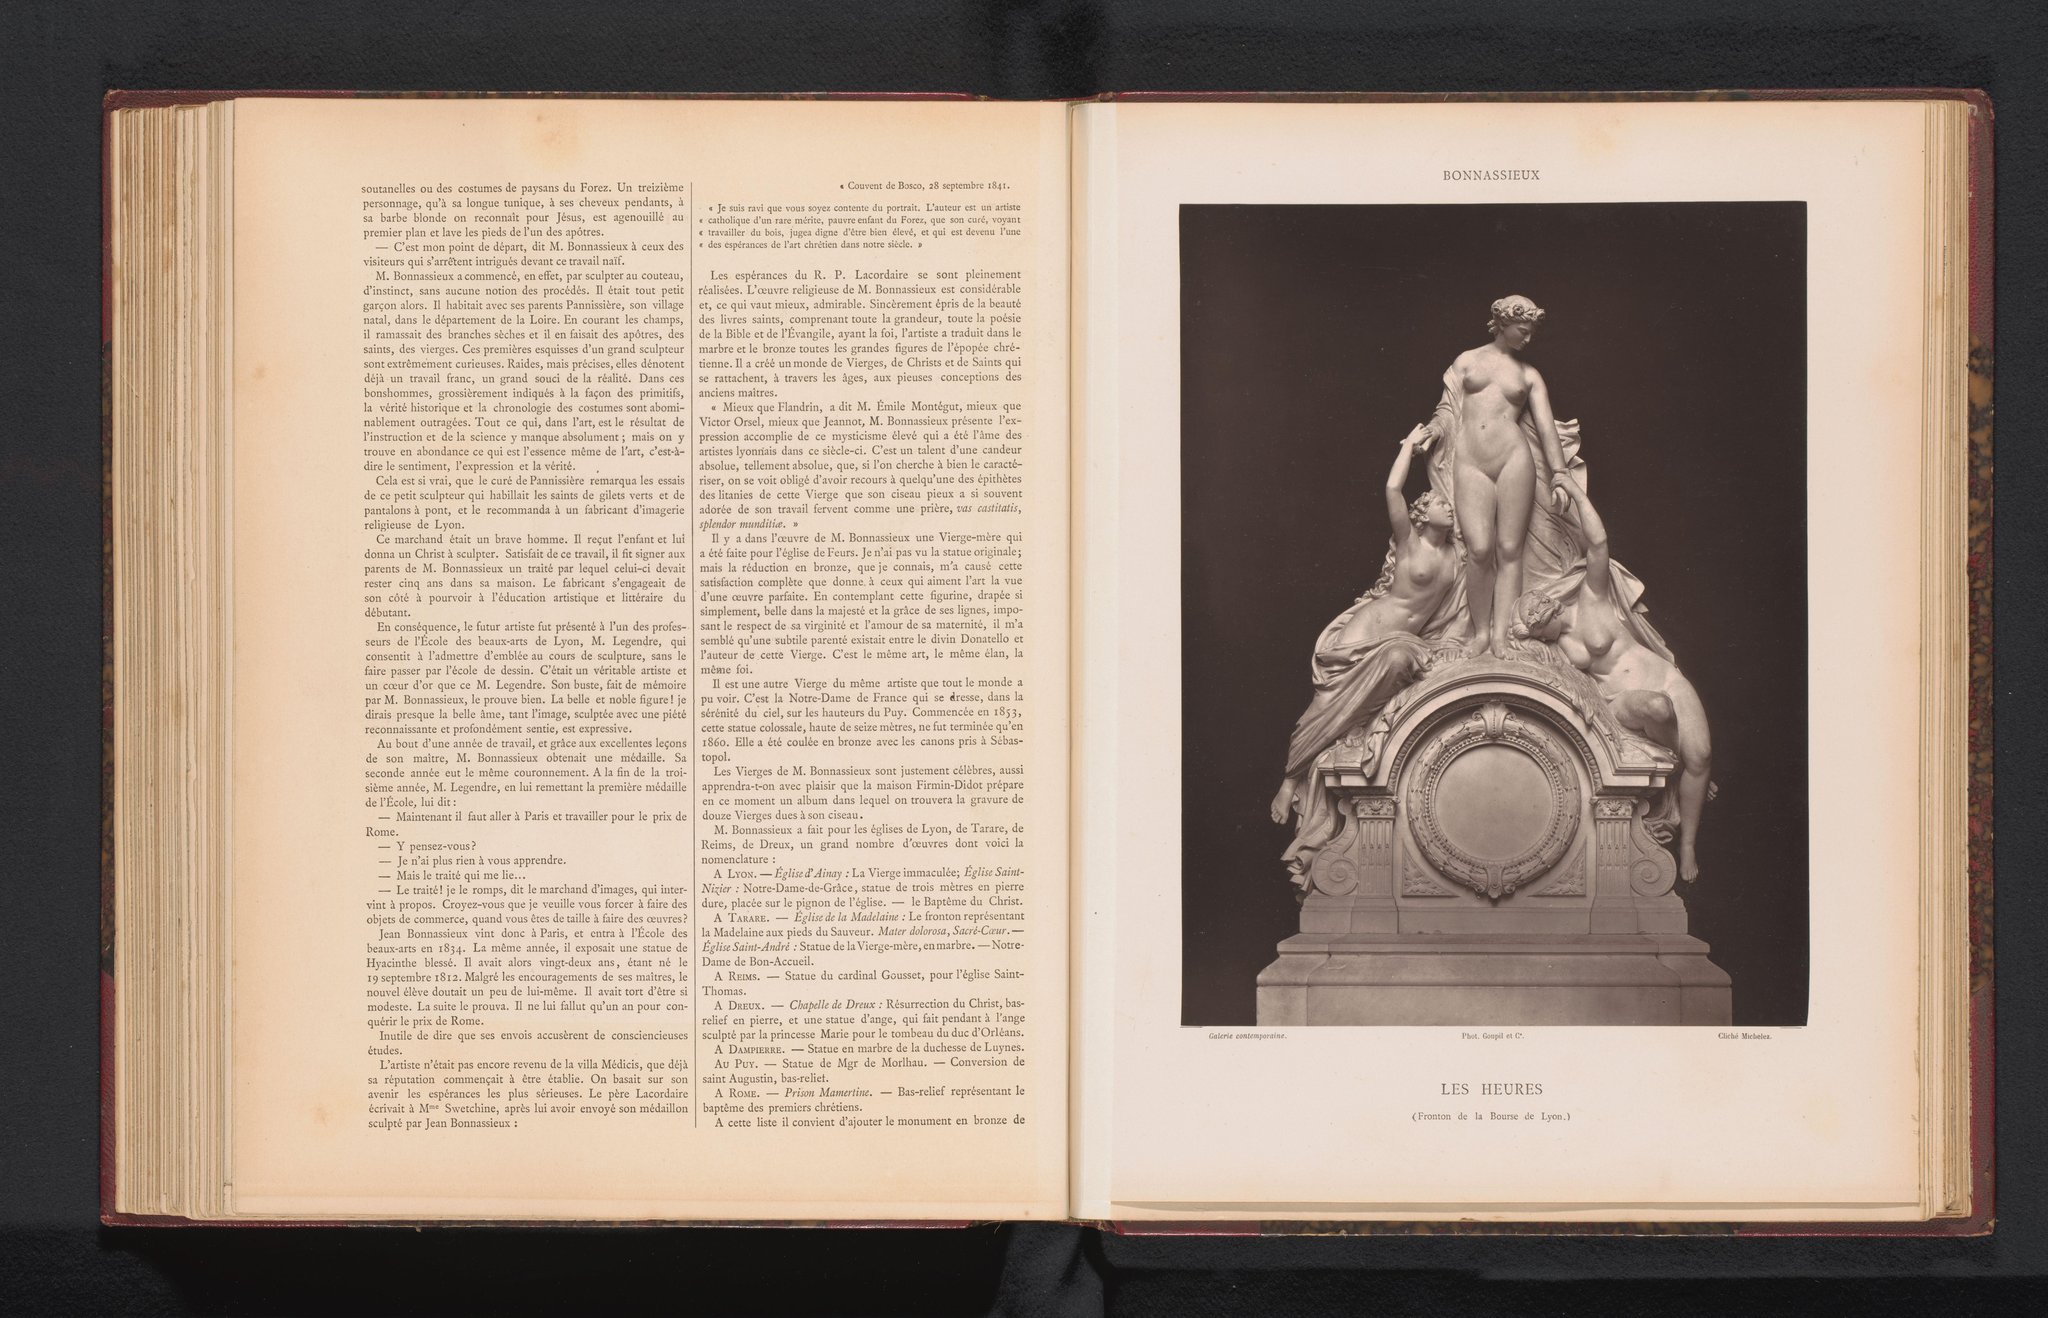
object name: photomechanical print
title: Les Heures - (Fronton de la Bourse de Lyon)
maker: charles michelez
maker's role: fotograaf, fotostudio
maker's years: 1817-1883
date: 1873-1878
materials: paper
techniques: woodburytype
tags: sculpture, allegory of time and eternity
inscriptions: inscription: ‘Bonnassieux/ Galerie Contemporaine’